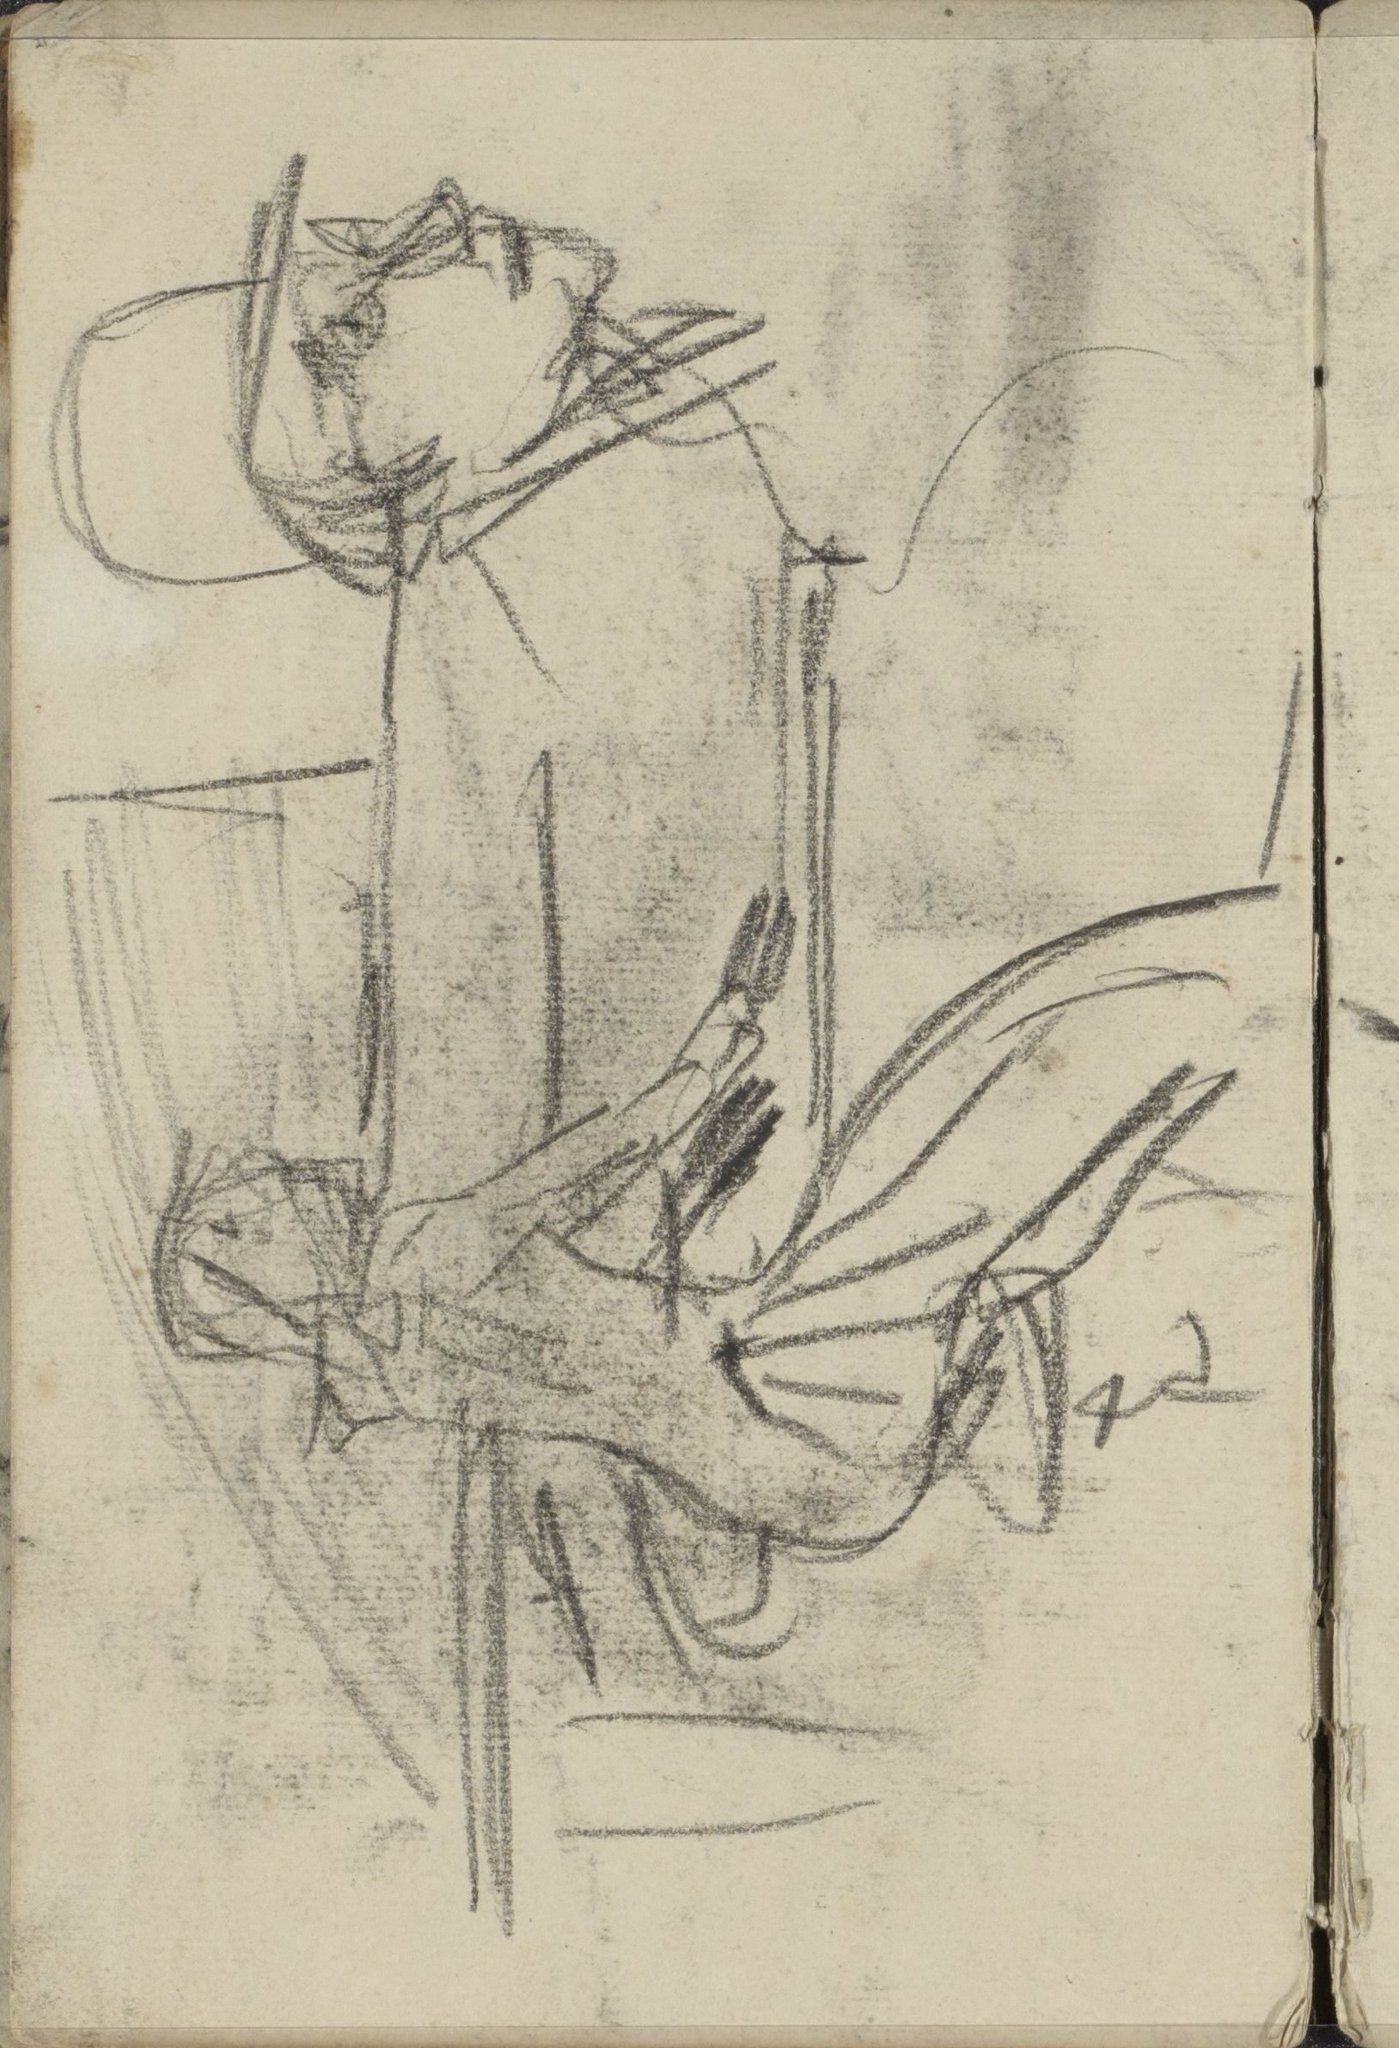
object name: sketchbook leaf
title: Vrouw aan een tafel en een mannenhoofd met hoed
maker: george hendrik breitner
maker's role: draughtsman, painter, print maker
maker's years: 1857-1923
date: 1887-1891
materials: chalk, paper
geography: amsterdam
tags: head (human), head-gear: hat, sitting on an elevation - aa - female human figure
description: Pagina 21 uit een schetsboek met 17 bladen.